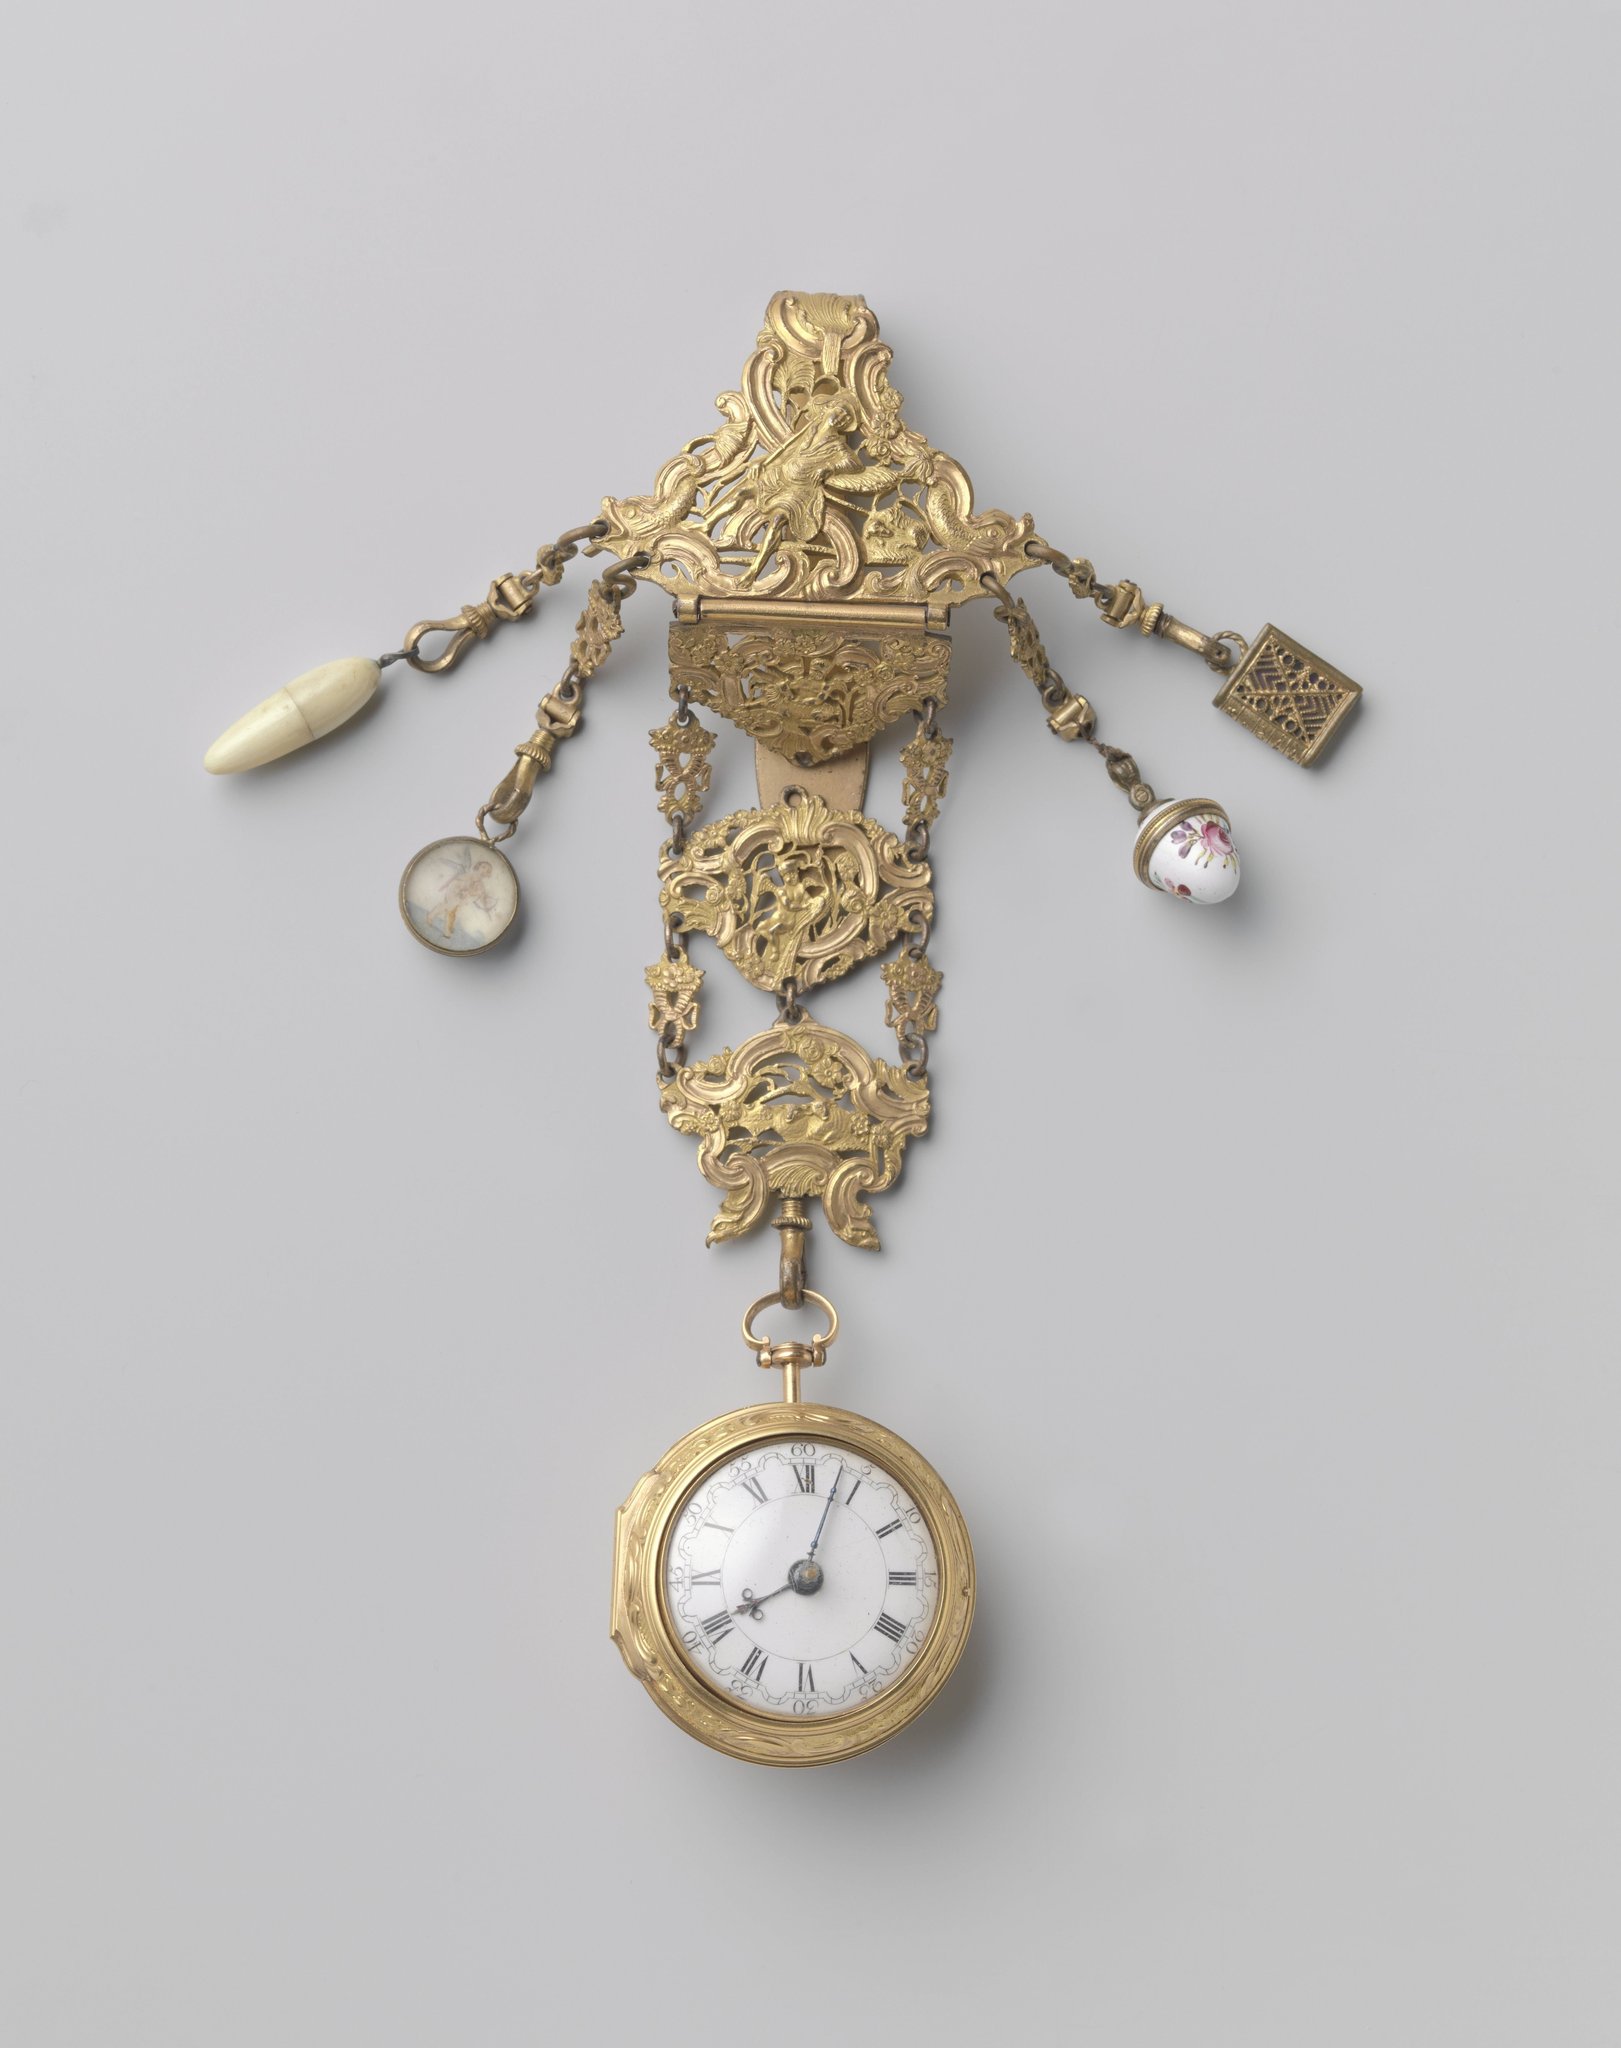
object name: chatelaine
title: Horloge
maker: Anonymous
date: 1778-1779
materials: copper, gold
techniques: gilding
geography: london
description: Gouden horloge aan chatelaine. De kast is versierd met een gedreven voorstelling van Hector's afscheid. Het horloge hangt aan een verguld koperen chatelaine.